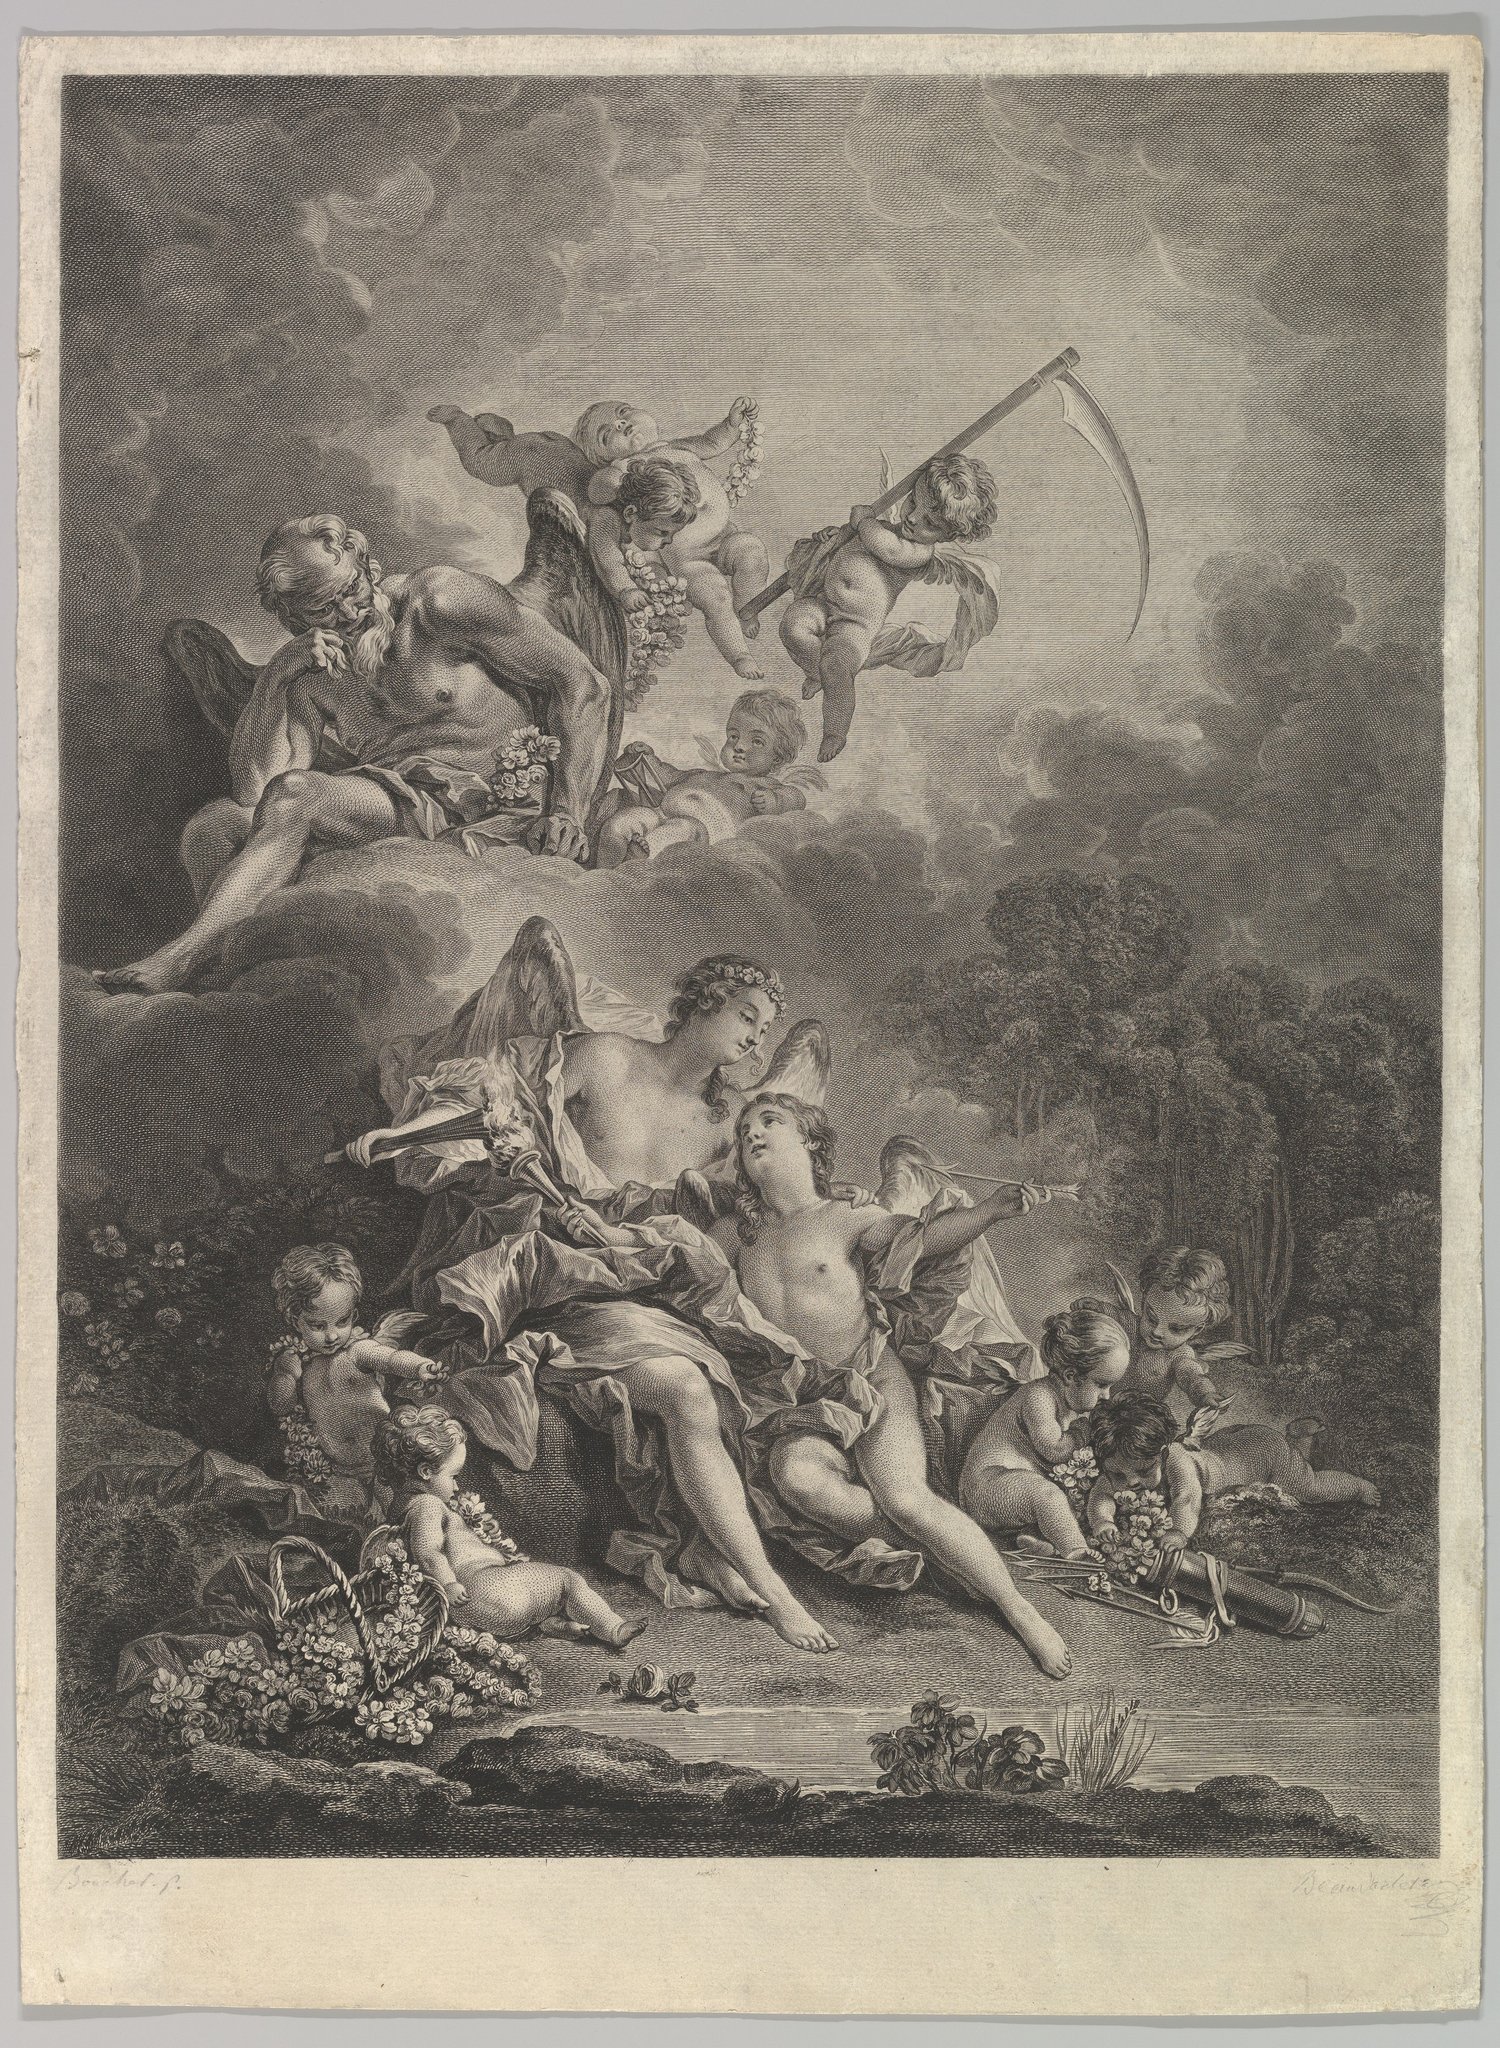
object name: print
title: L'Hymen et l'Amour (Hymen and Cupid)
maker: jacques firmin beauvarlet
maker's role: artist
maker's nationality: french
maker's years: 1731-1797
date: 1701-1800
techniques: engraving, etching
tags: men,cupid